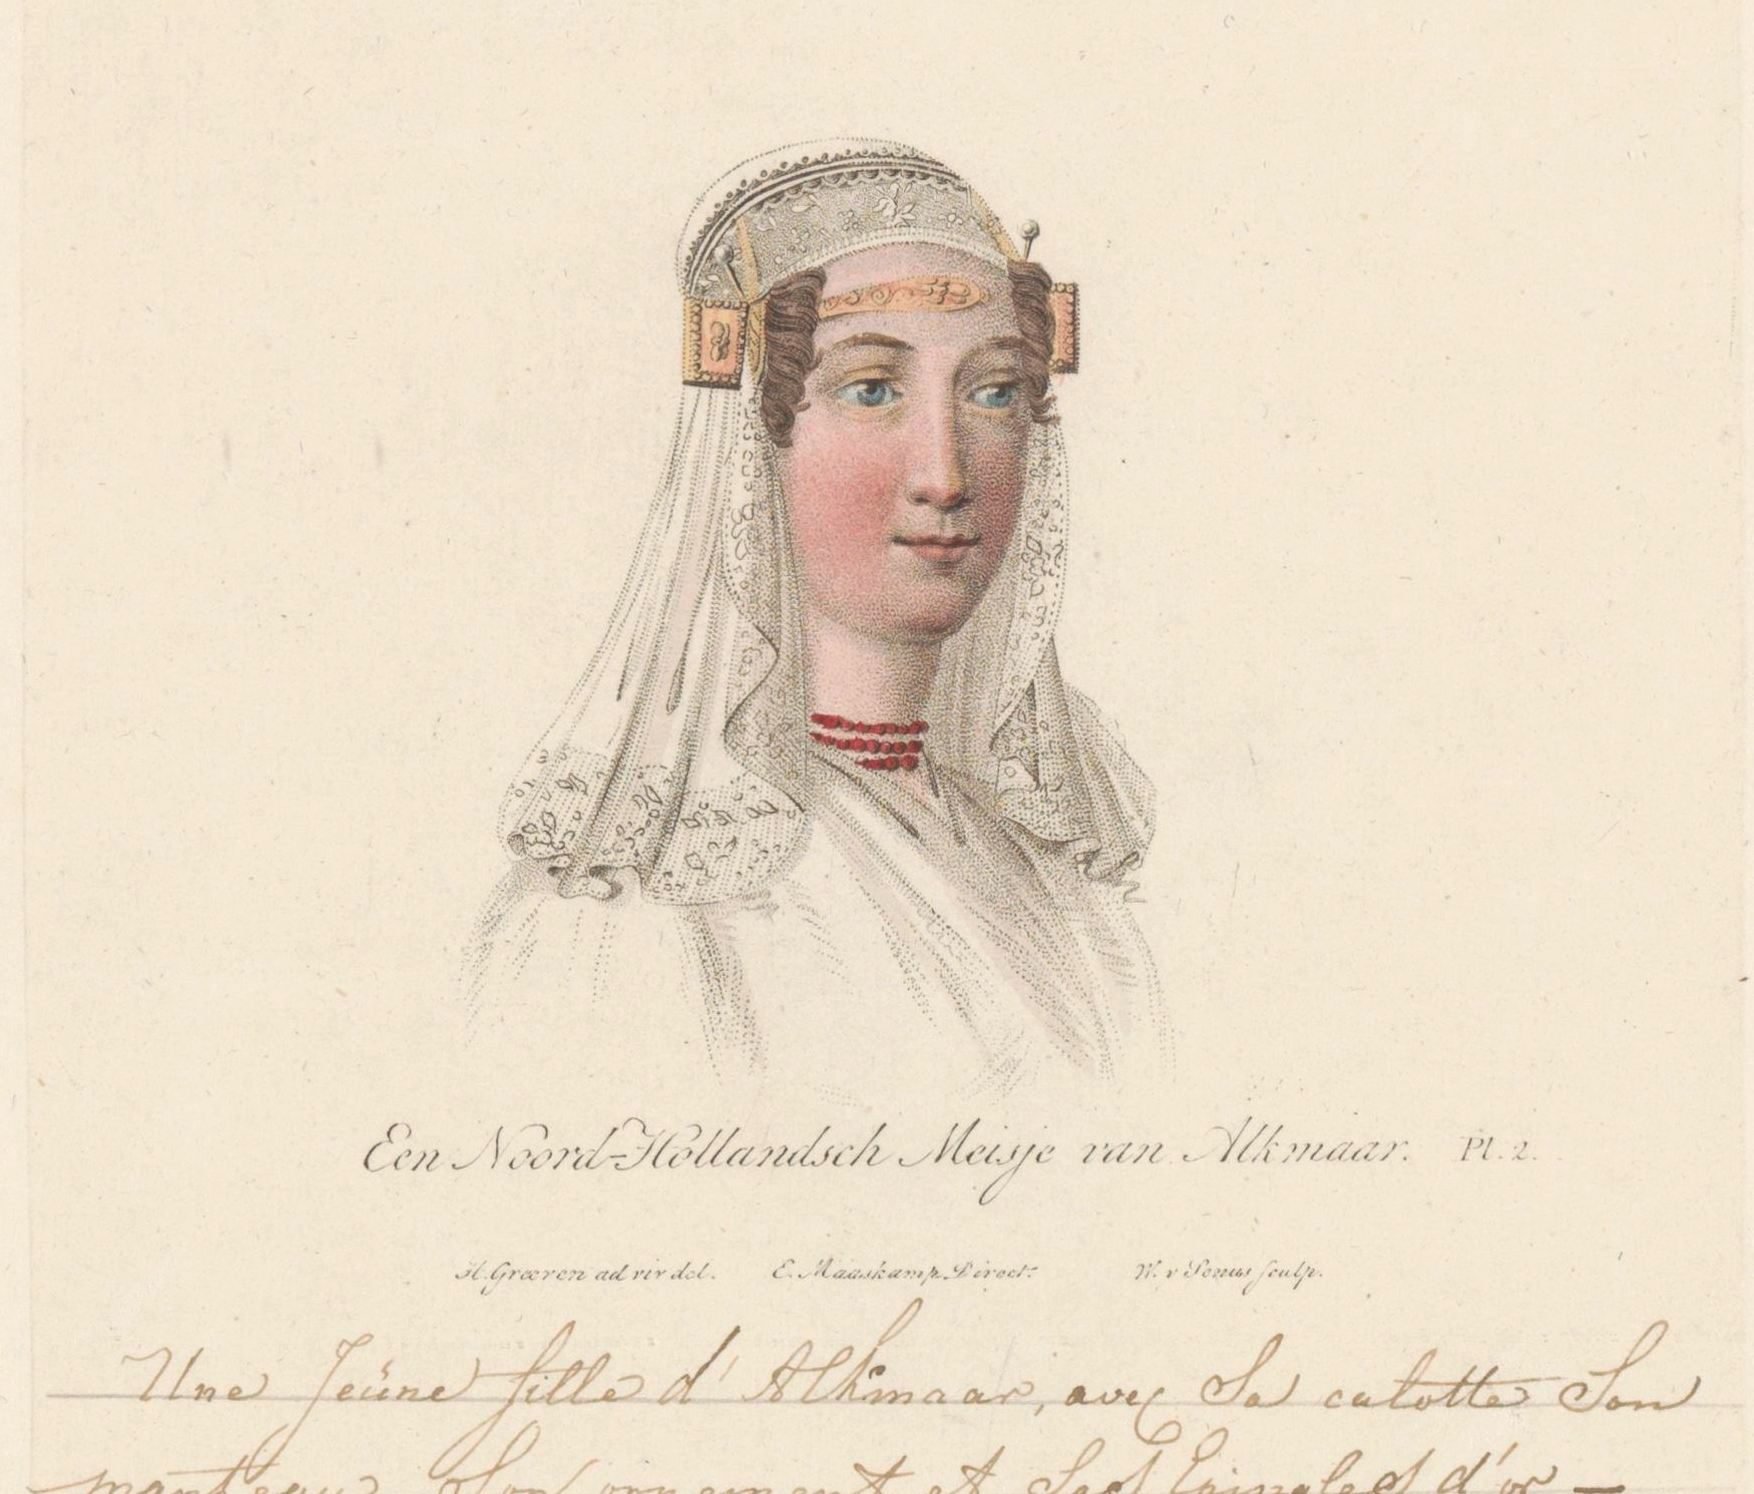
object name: costume print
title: Hoofddracht van een meisje uit Alkmaar, 1816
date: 1816-1817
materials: paper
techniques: etching, hand coloring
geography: netherlands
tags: folk costume, regional costume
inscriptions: inscription: ‘Une Jeune d'Alkmaar, avec sa calottes son manteau son ornament et ses Epingles d'or’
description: Buste van een jonge vrouw uit Alkmaar in klederdracht, 1816. Rechtsonder genummerd: Pl. 2. Onderdeel van een plaatwerk uit ca. 1824-1825 met 74 (ongenummerde) platen van de belangrijkste topografische gezichten en verschillende zeden en gewoonten in het Verenigd Koninkrijk der Nederlanden.